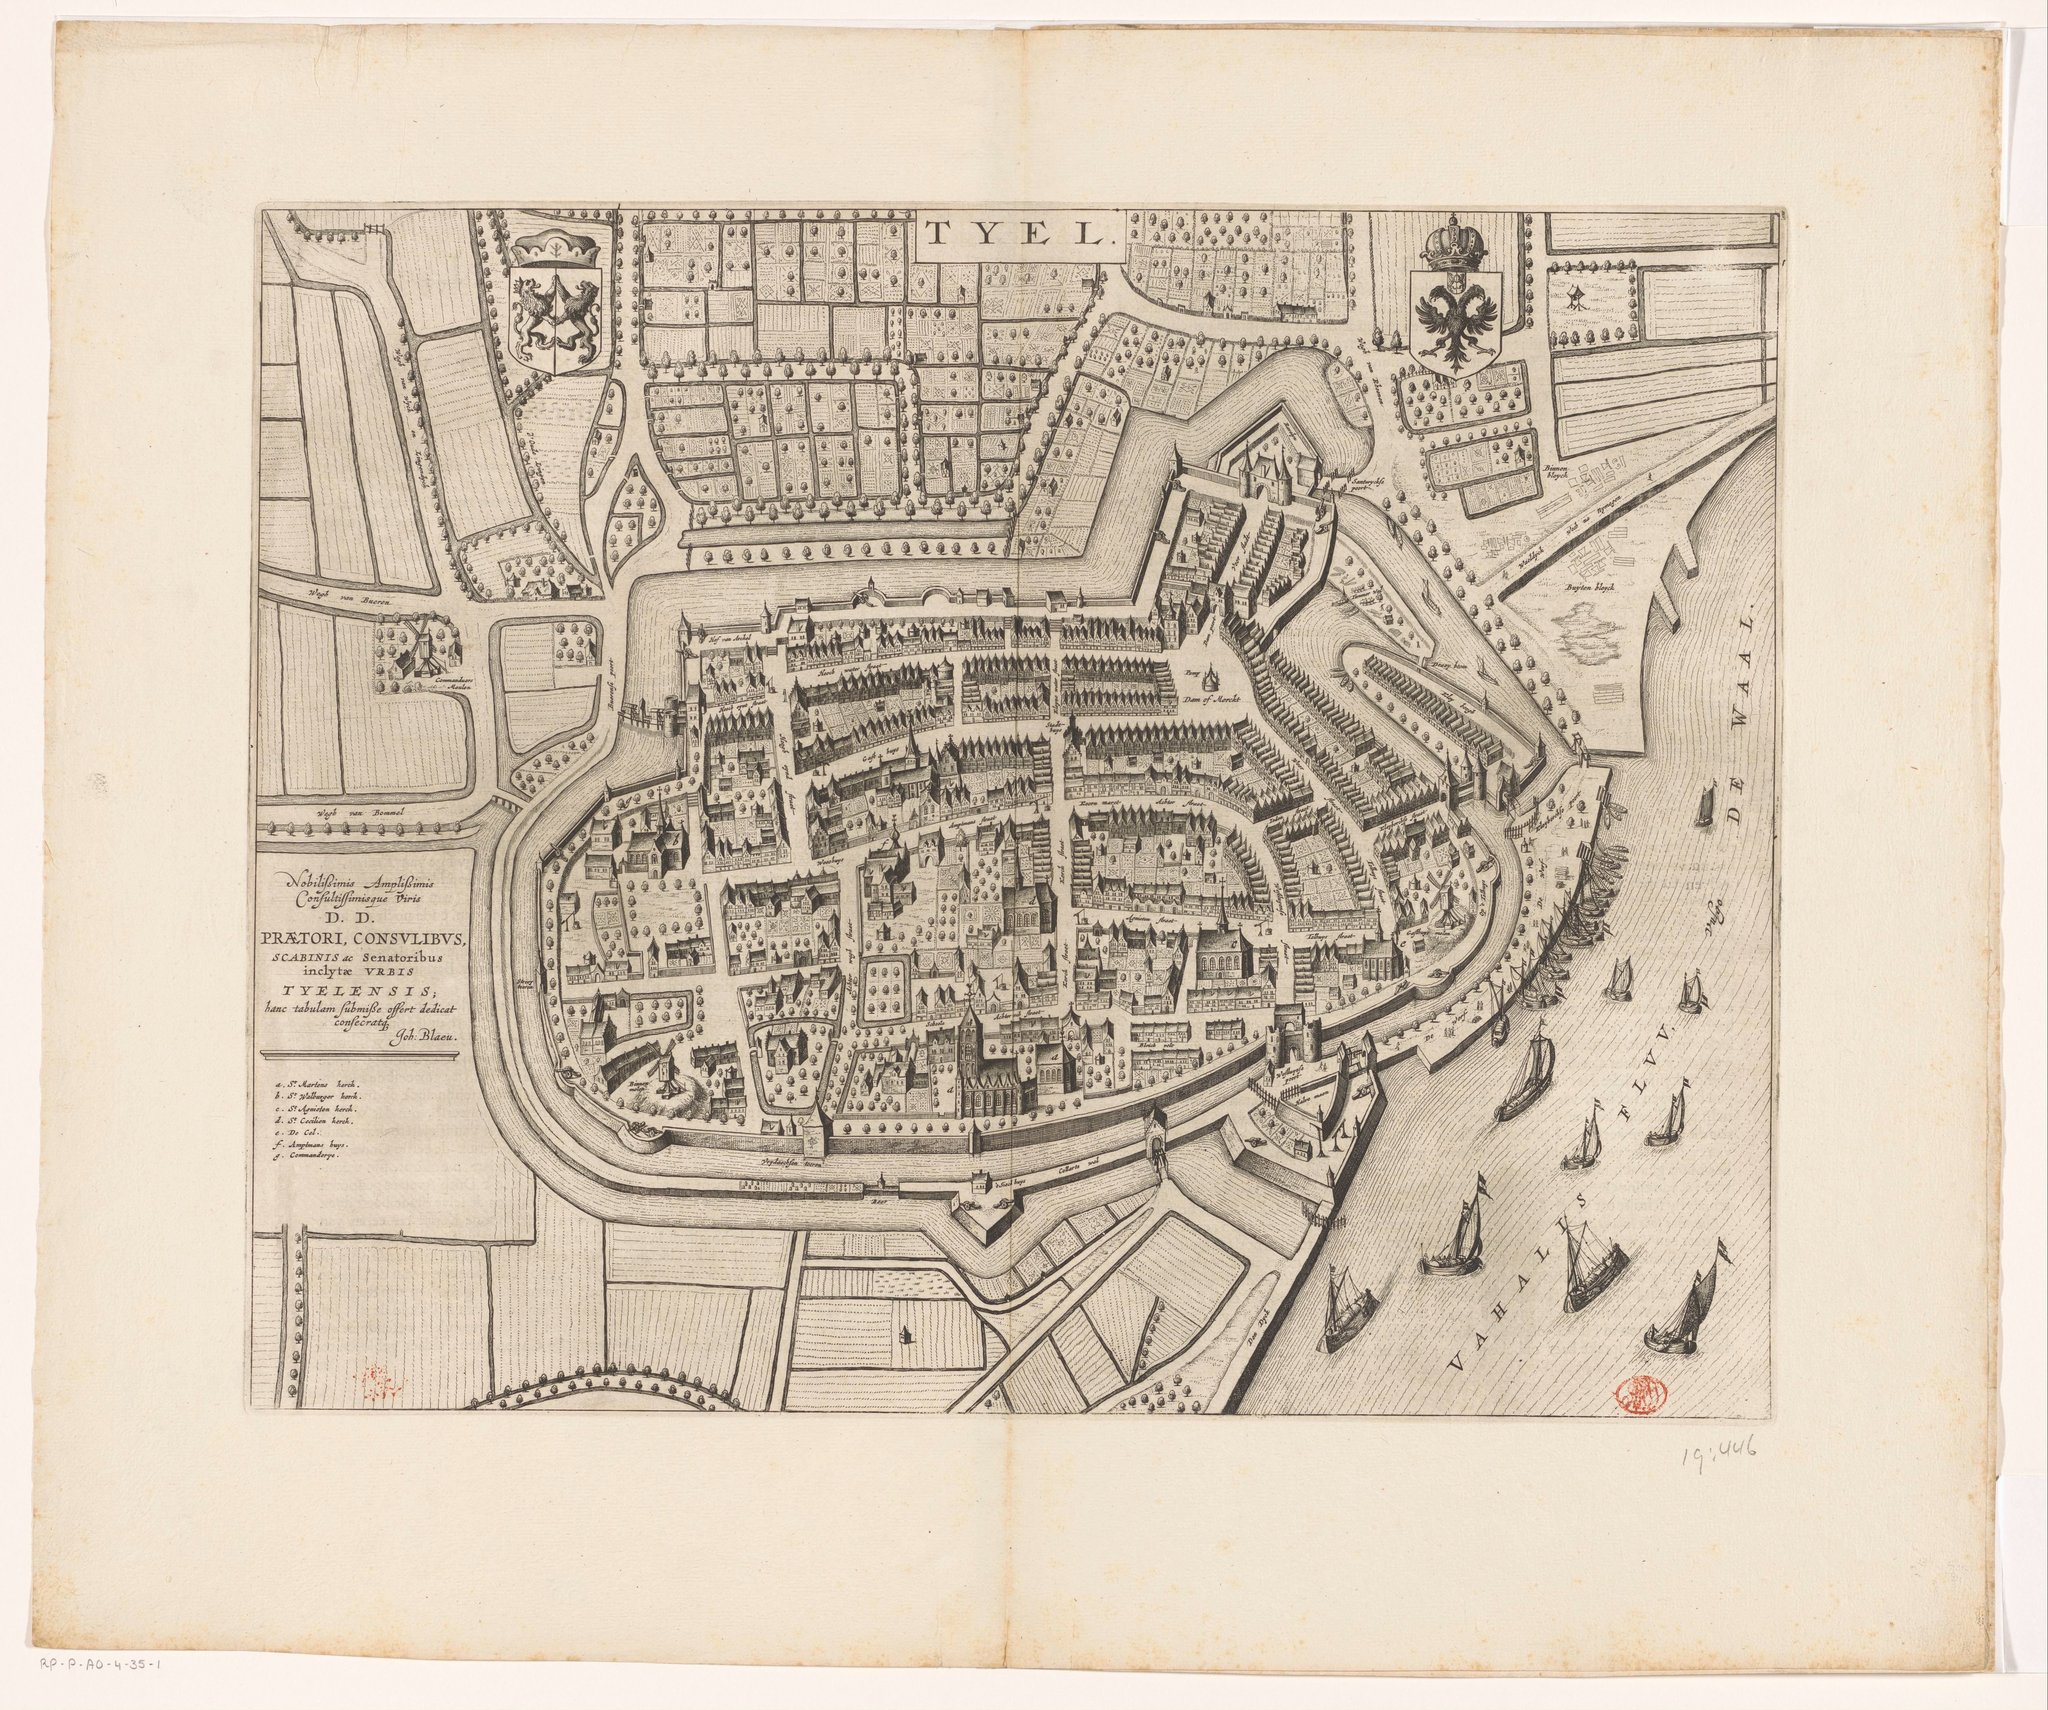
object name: area plan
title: Plattegrond van Tiel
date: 1652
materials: paper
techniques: engraving, etching, letterpress printing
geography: amsterdam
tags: coat of arms (as symbol of the state, etc.), maps of cities, gelderland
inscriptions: collector's mark: Lugt 2233, collector's mark: Lugt 195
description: Plattegrond in vogelvluchtperspectief. Linksboven het wapen van Gelderland. Links de opdracht met daaronder de legenda. Rechtsboven het wapen van Tiel. Op verso Nederlandse tekst.